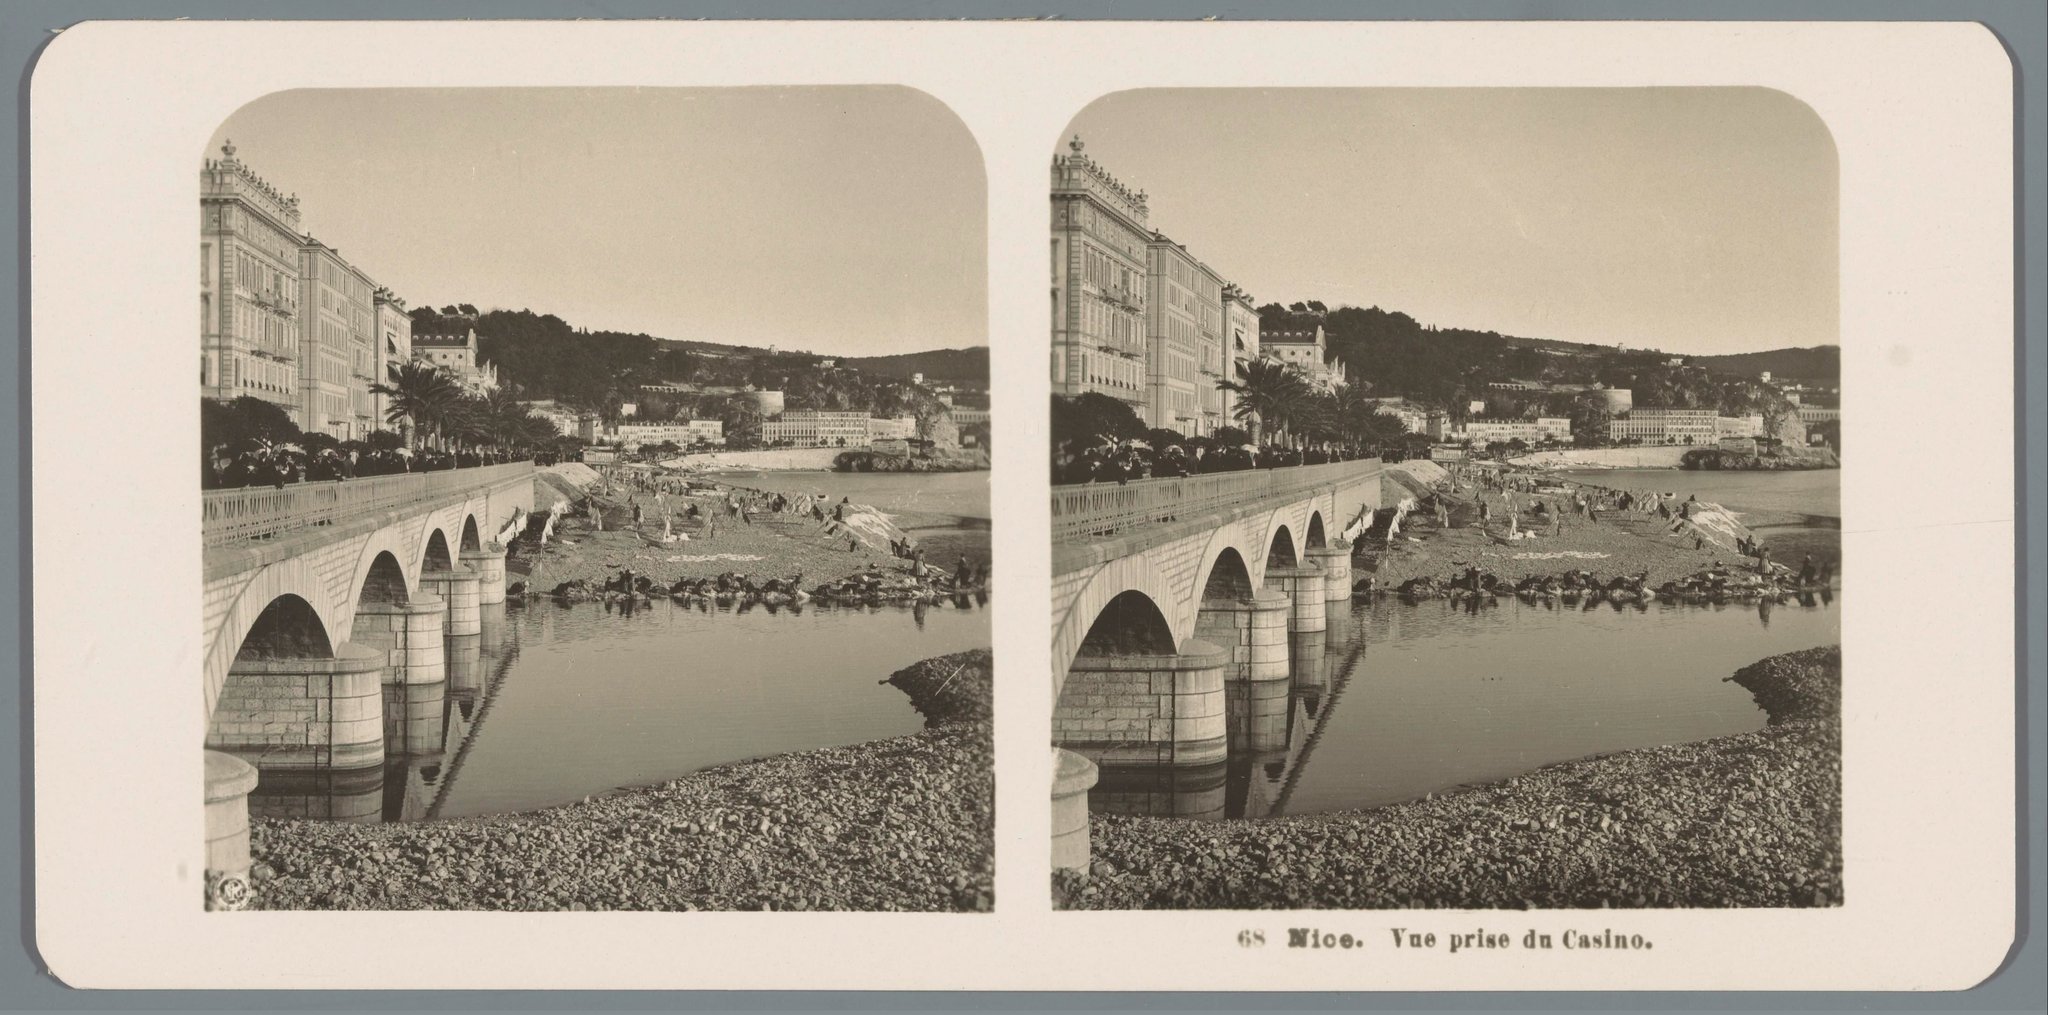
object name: stereograph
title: Nice. Vue prise du Casino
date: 1904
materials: cardboard, photographic support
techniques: gelatin silver print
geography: nice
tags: city-view in general; 'veduta', bridge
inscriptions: inscription: ‘NPG’, number: ‘68’